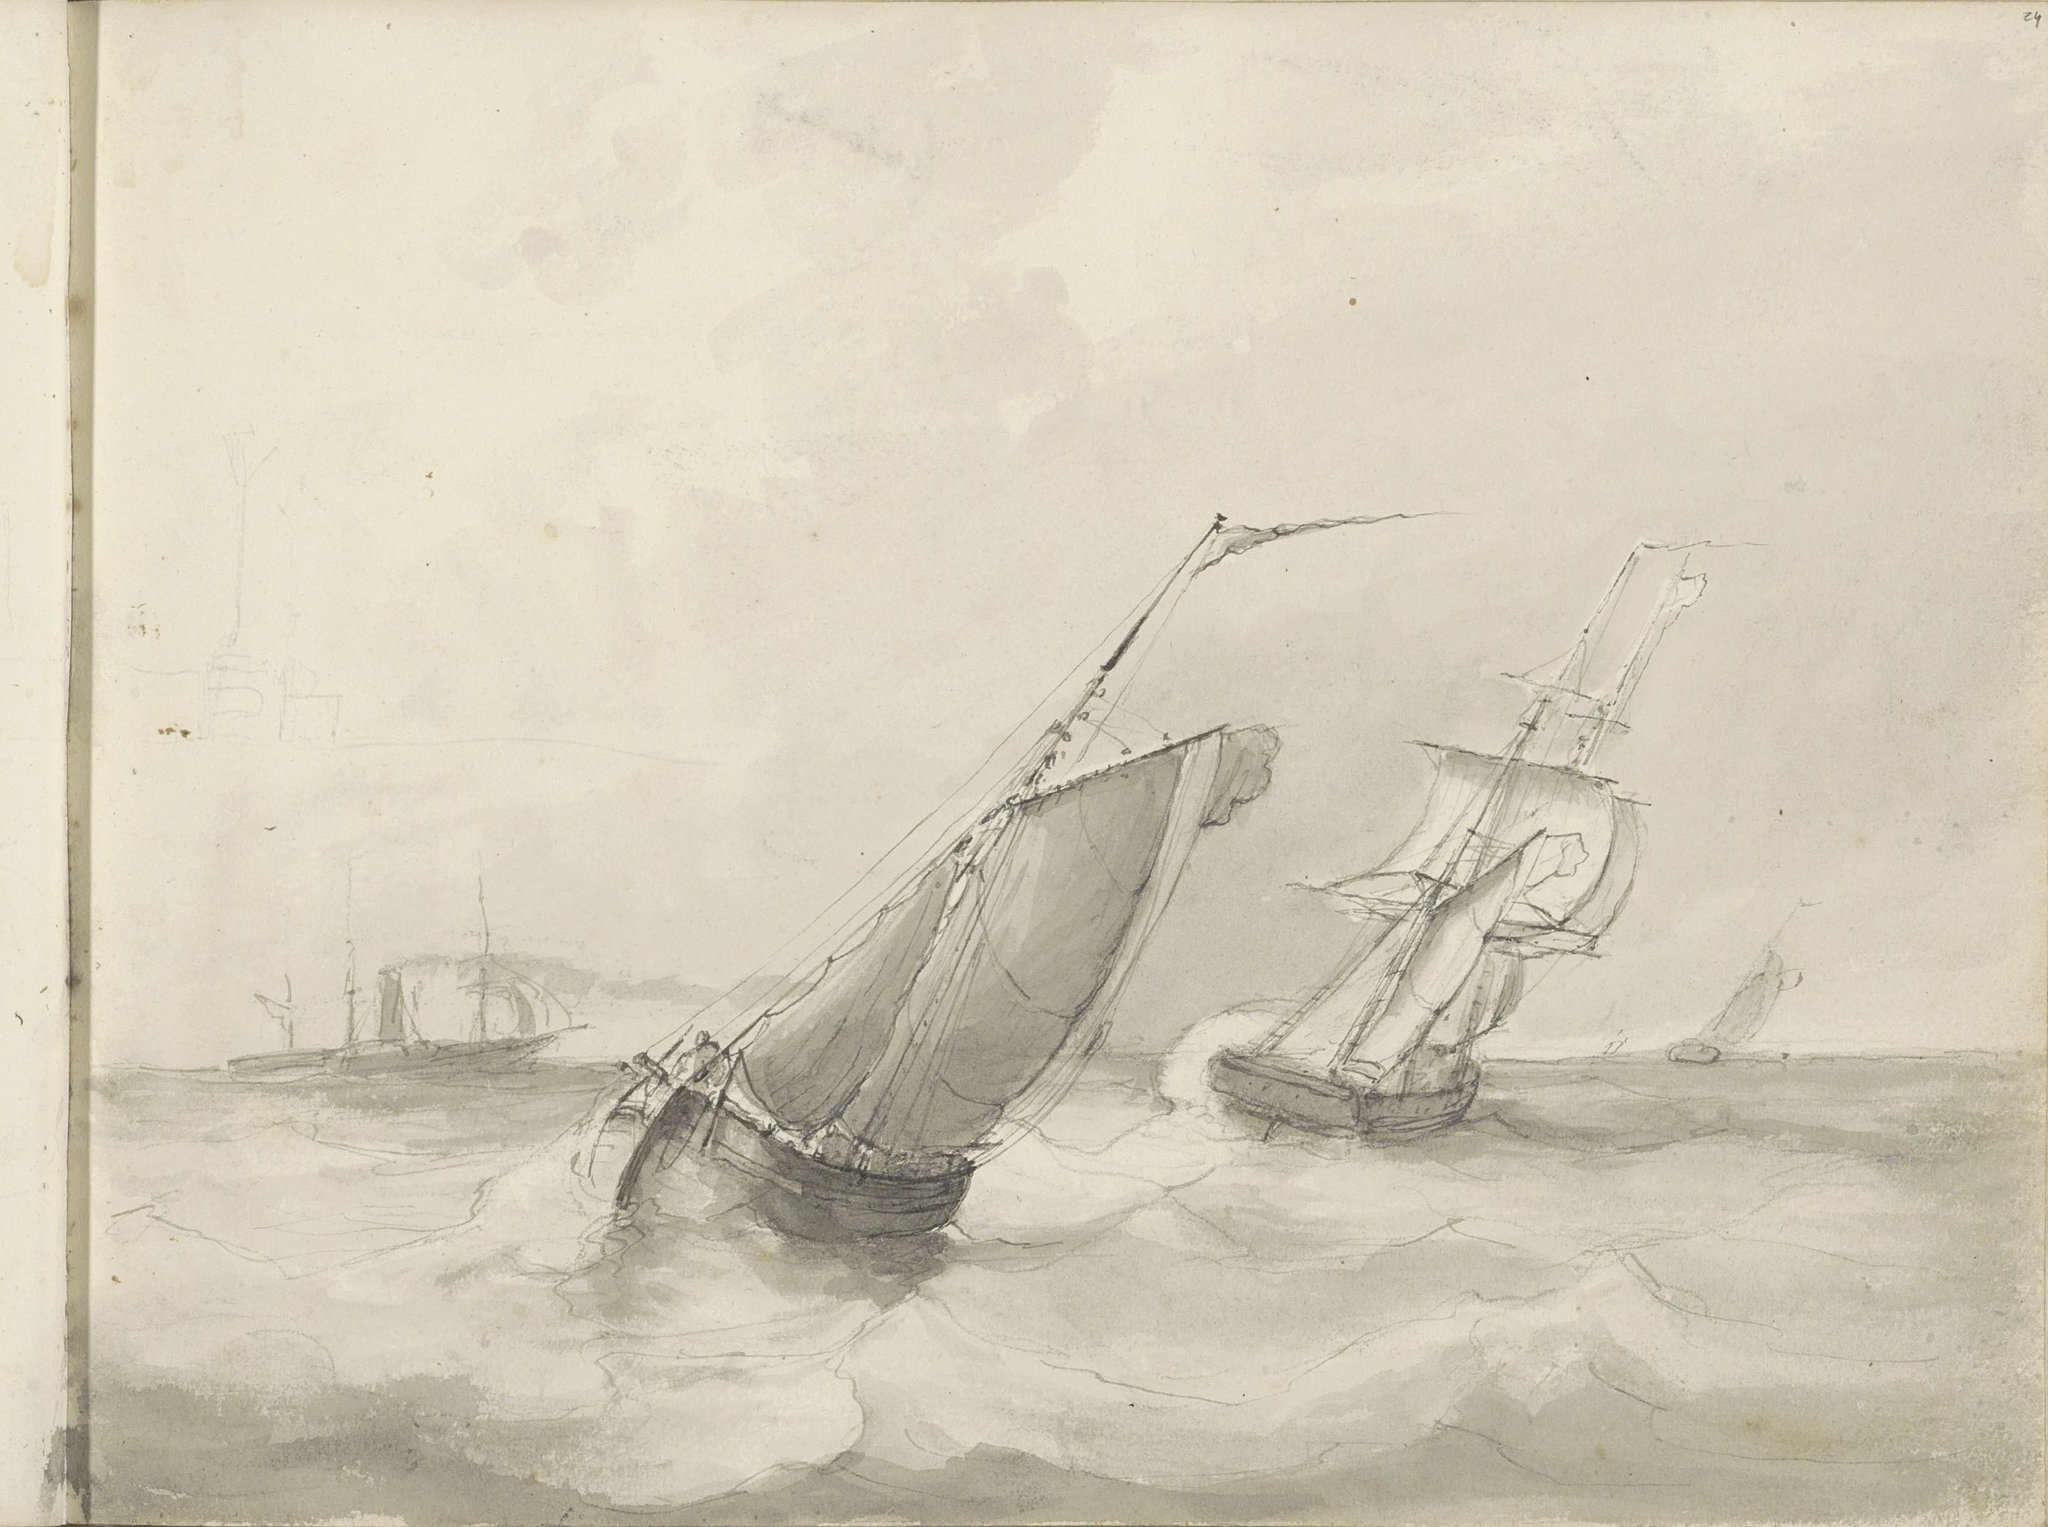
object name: sketchbook leaf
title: Zeilschepen op zee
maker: petrus johannes schotel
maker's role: draughtsman, painter, print maker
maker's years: 1808-1865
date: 1825-1875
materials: ink, paper, pencil, watercolor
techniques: brush, pen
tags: sea (seascape)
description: Blad 24 recto uit een schetsboek met 44 bladen.